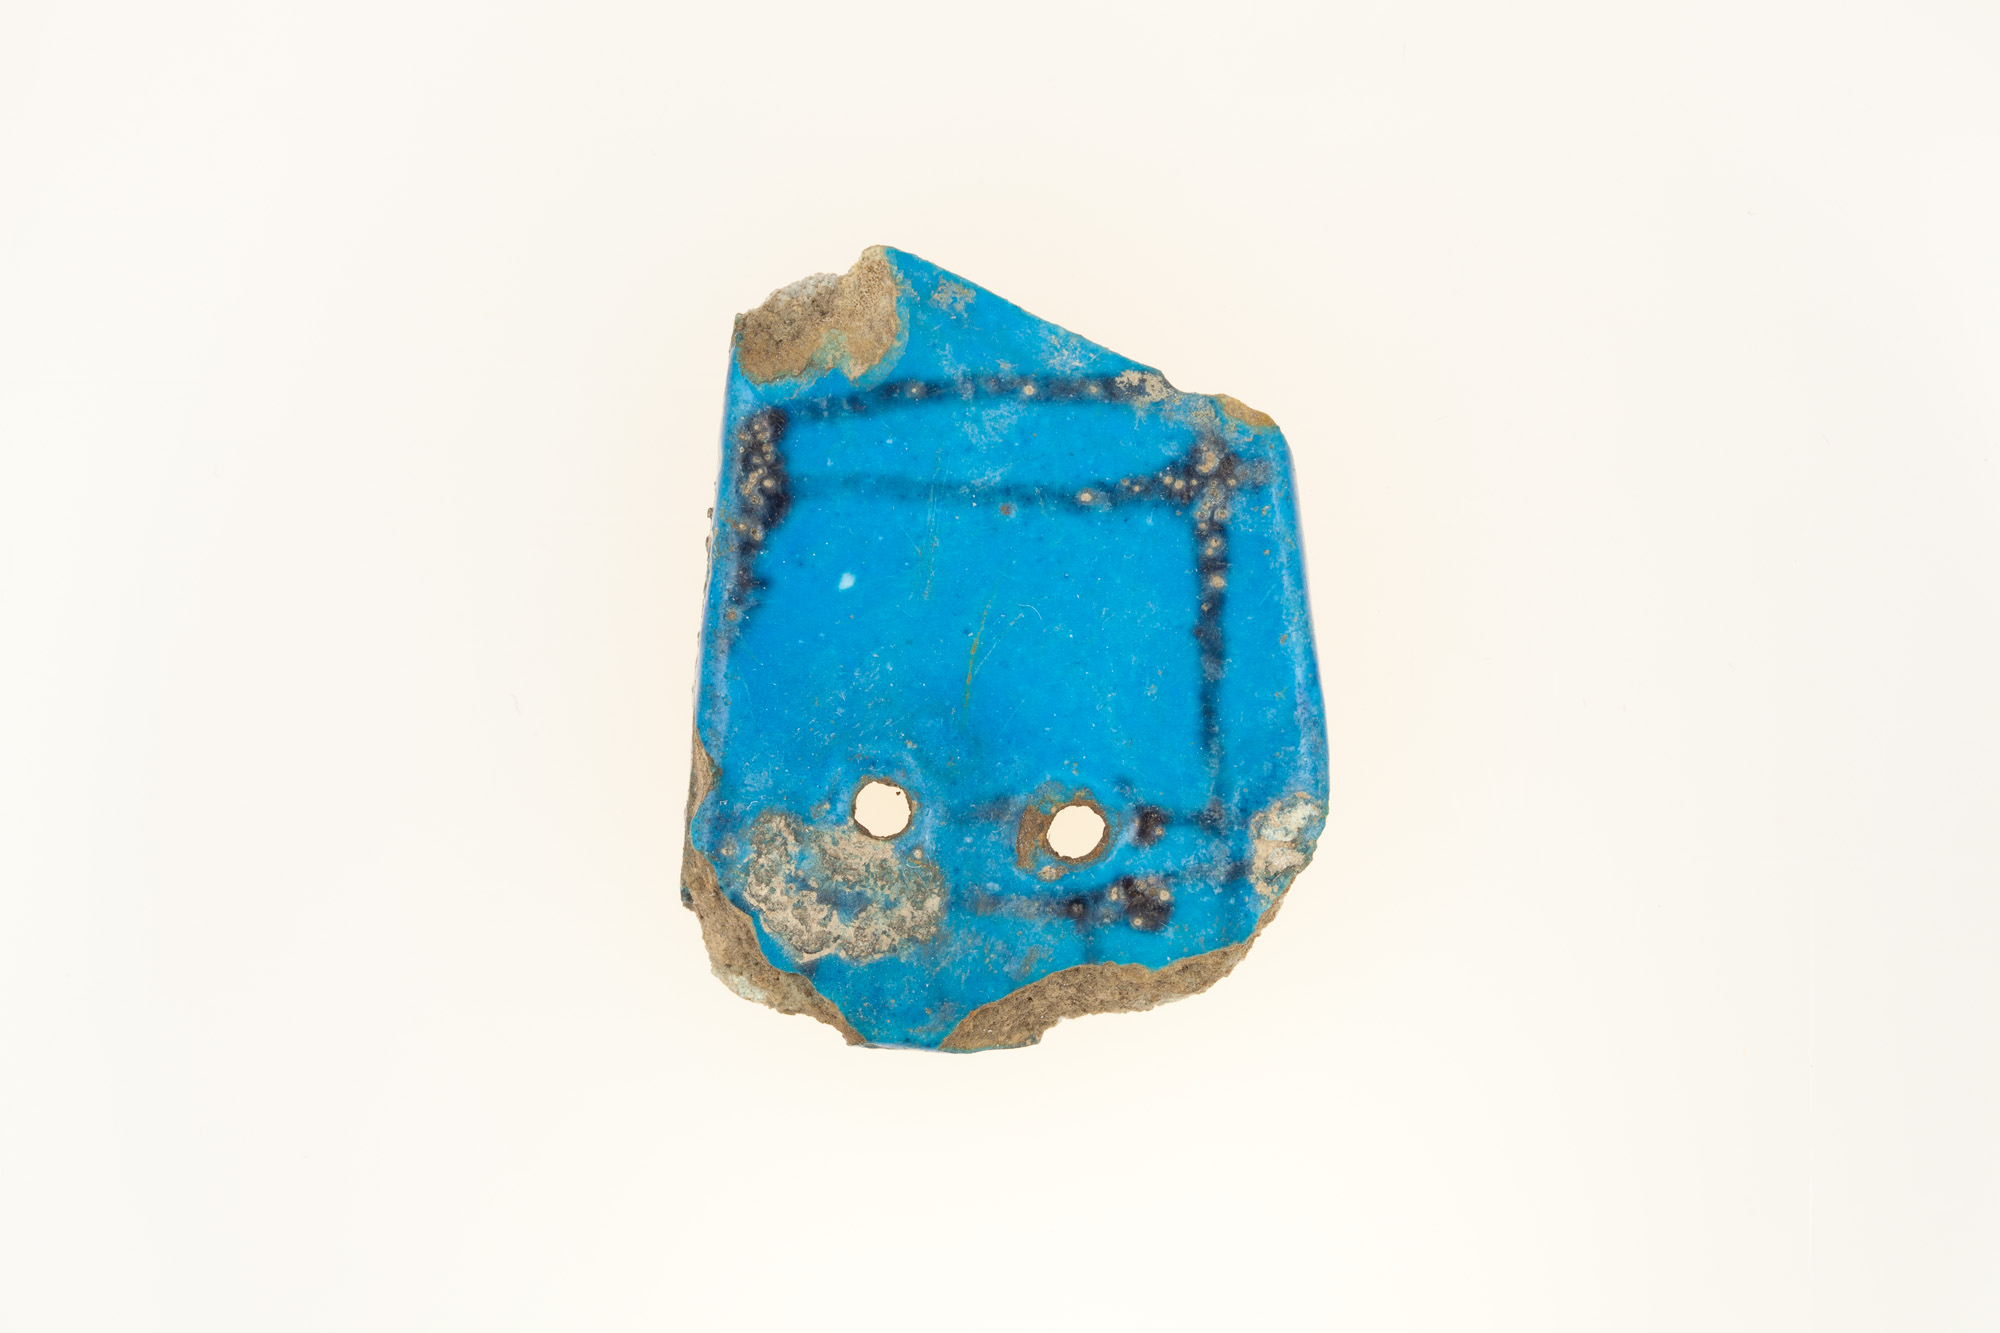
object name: menat fragment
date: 1479-1458 BCE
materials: faience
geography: egypt